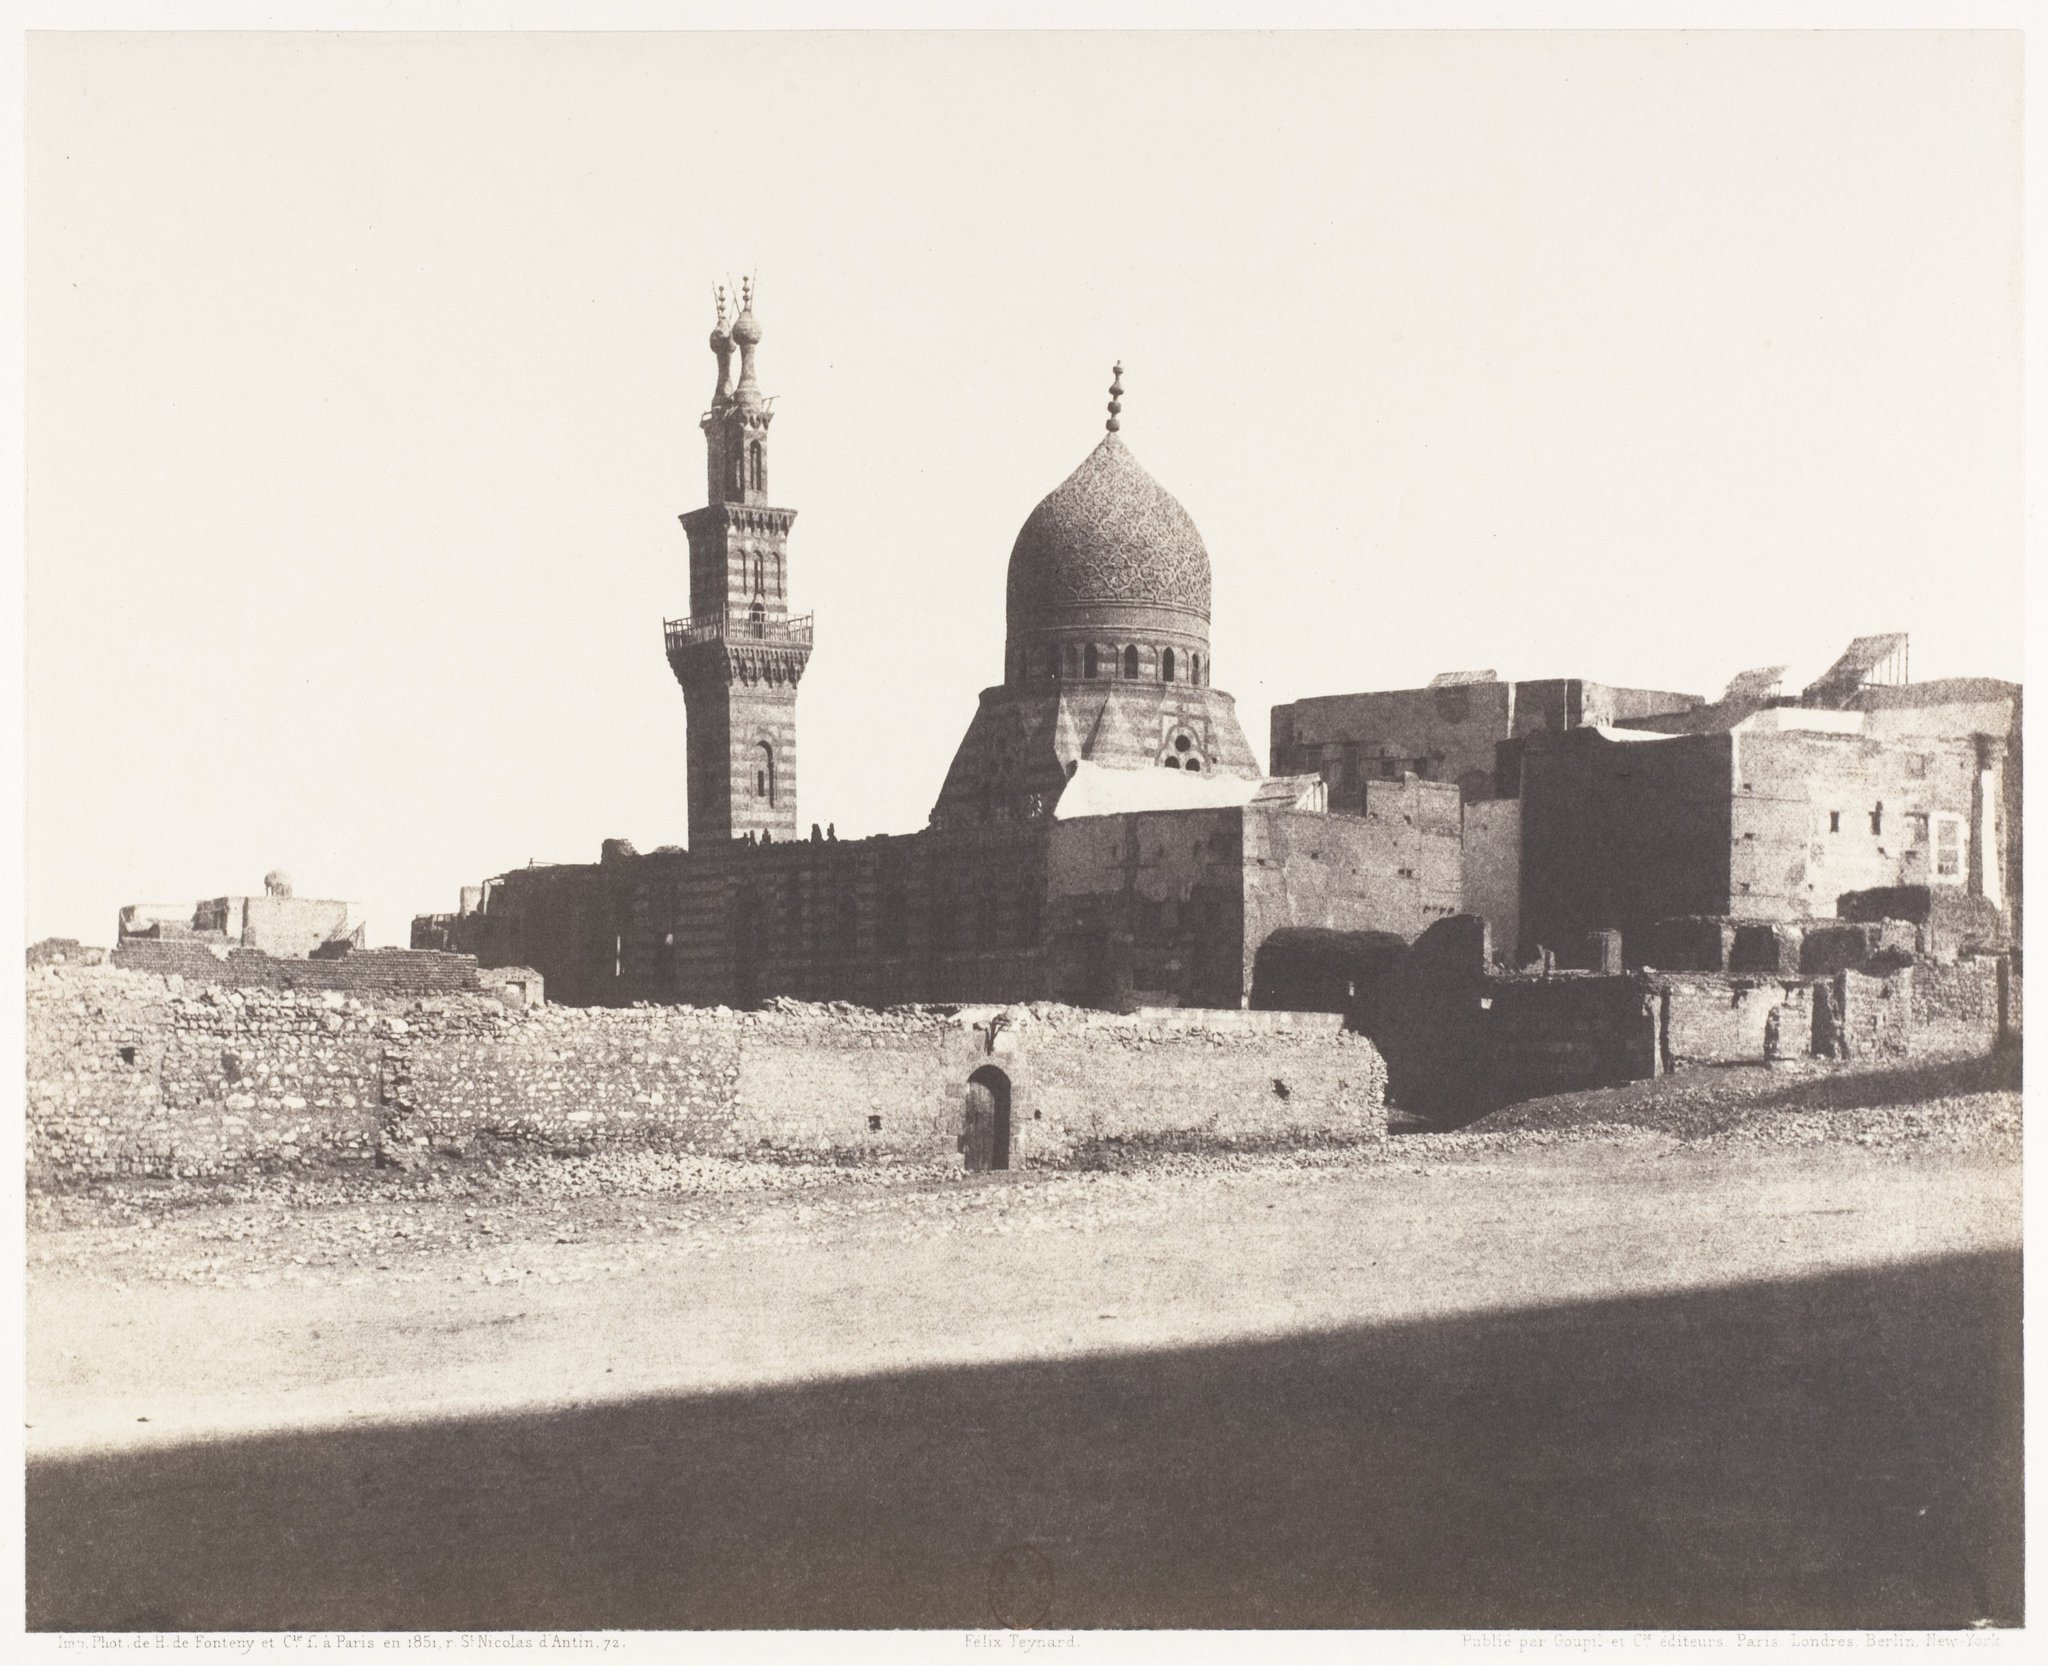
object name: photograph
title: Le Kaire, Mosquée Nâcéryeh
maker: félix teynard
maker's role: artist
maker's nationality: french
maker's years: 1817-1892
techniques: paper negative, salted paper print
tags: architecture,mosques